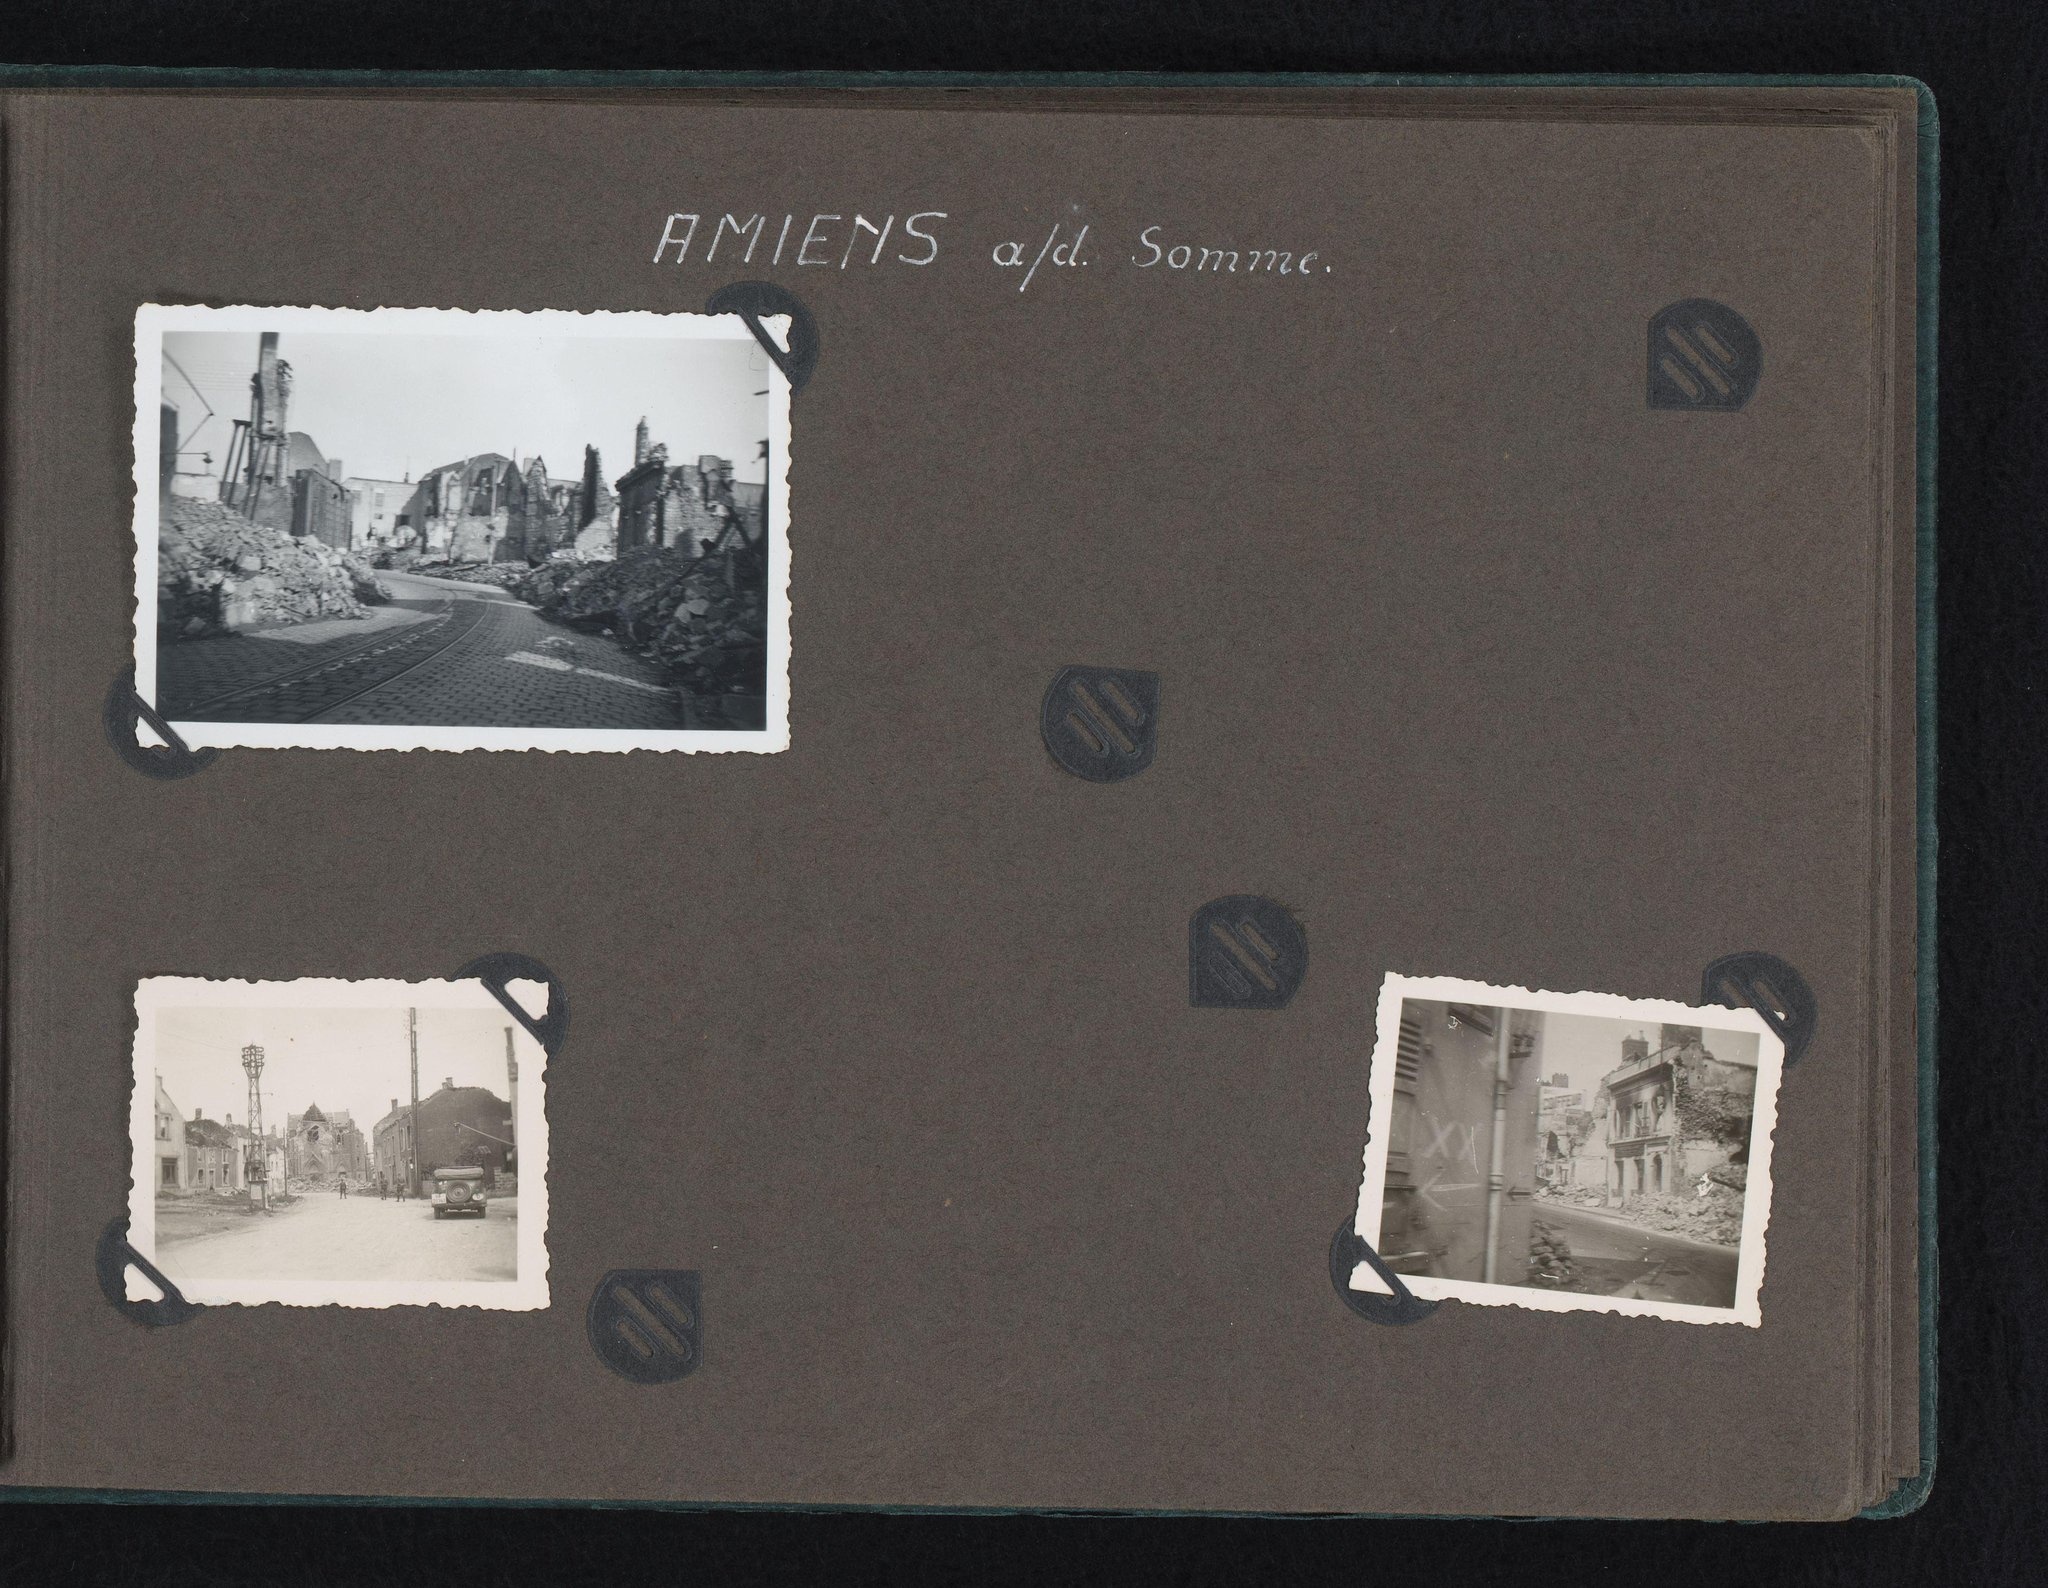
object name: album leaf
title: Amiens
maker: Anonymous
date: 1940-1945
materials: cardboard, photographic support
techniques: gelatin silver print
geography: france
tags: devastated, ruined place or city (~ warfare), france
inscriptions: inscription: ‘Amiens a/d. Somme’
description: Albumblad met drie foto's van de gevolgen van de oorlog in Amiens, Frankrijk. Onderdeel van het fotoalbum 'Kriegserinnerungen' 1940-1945.